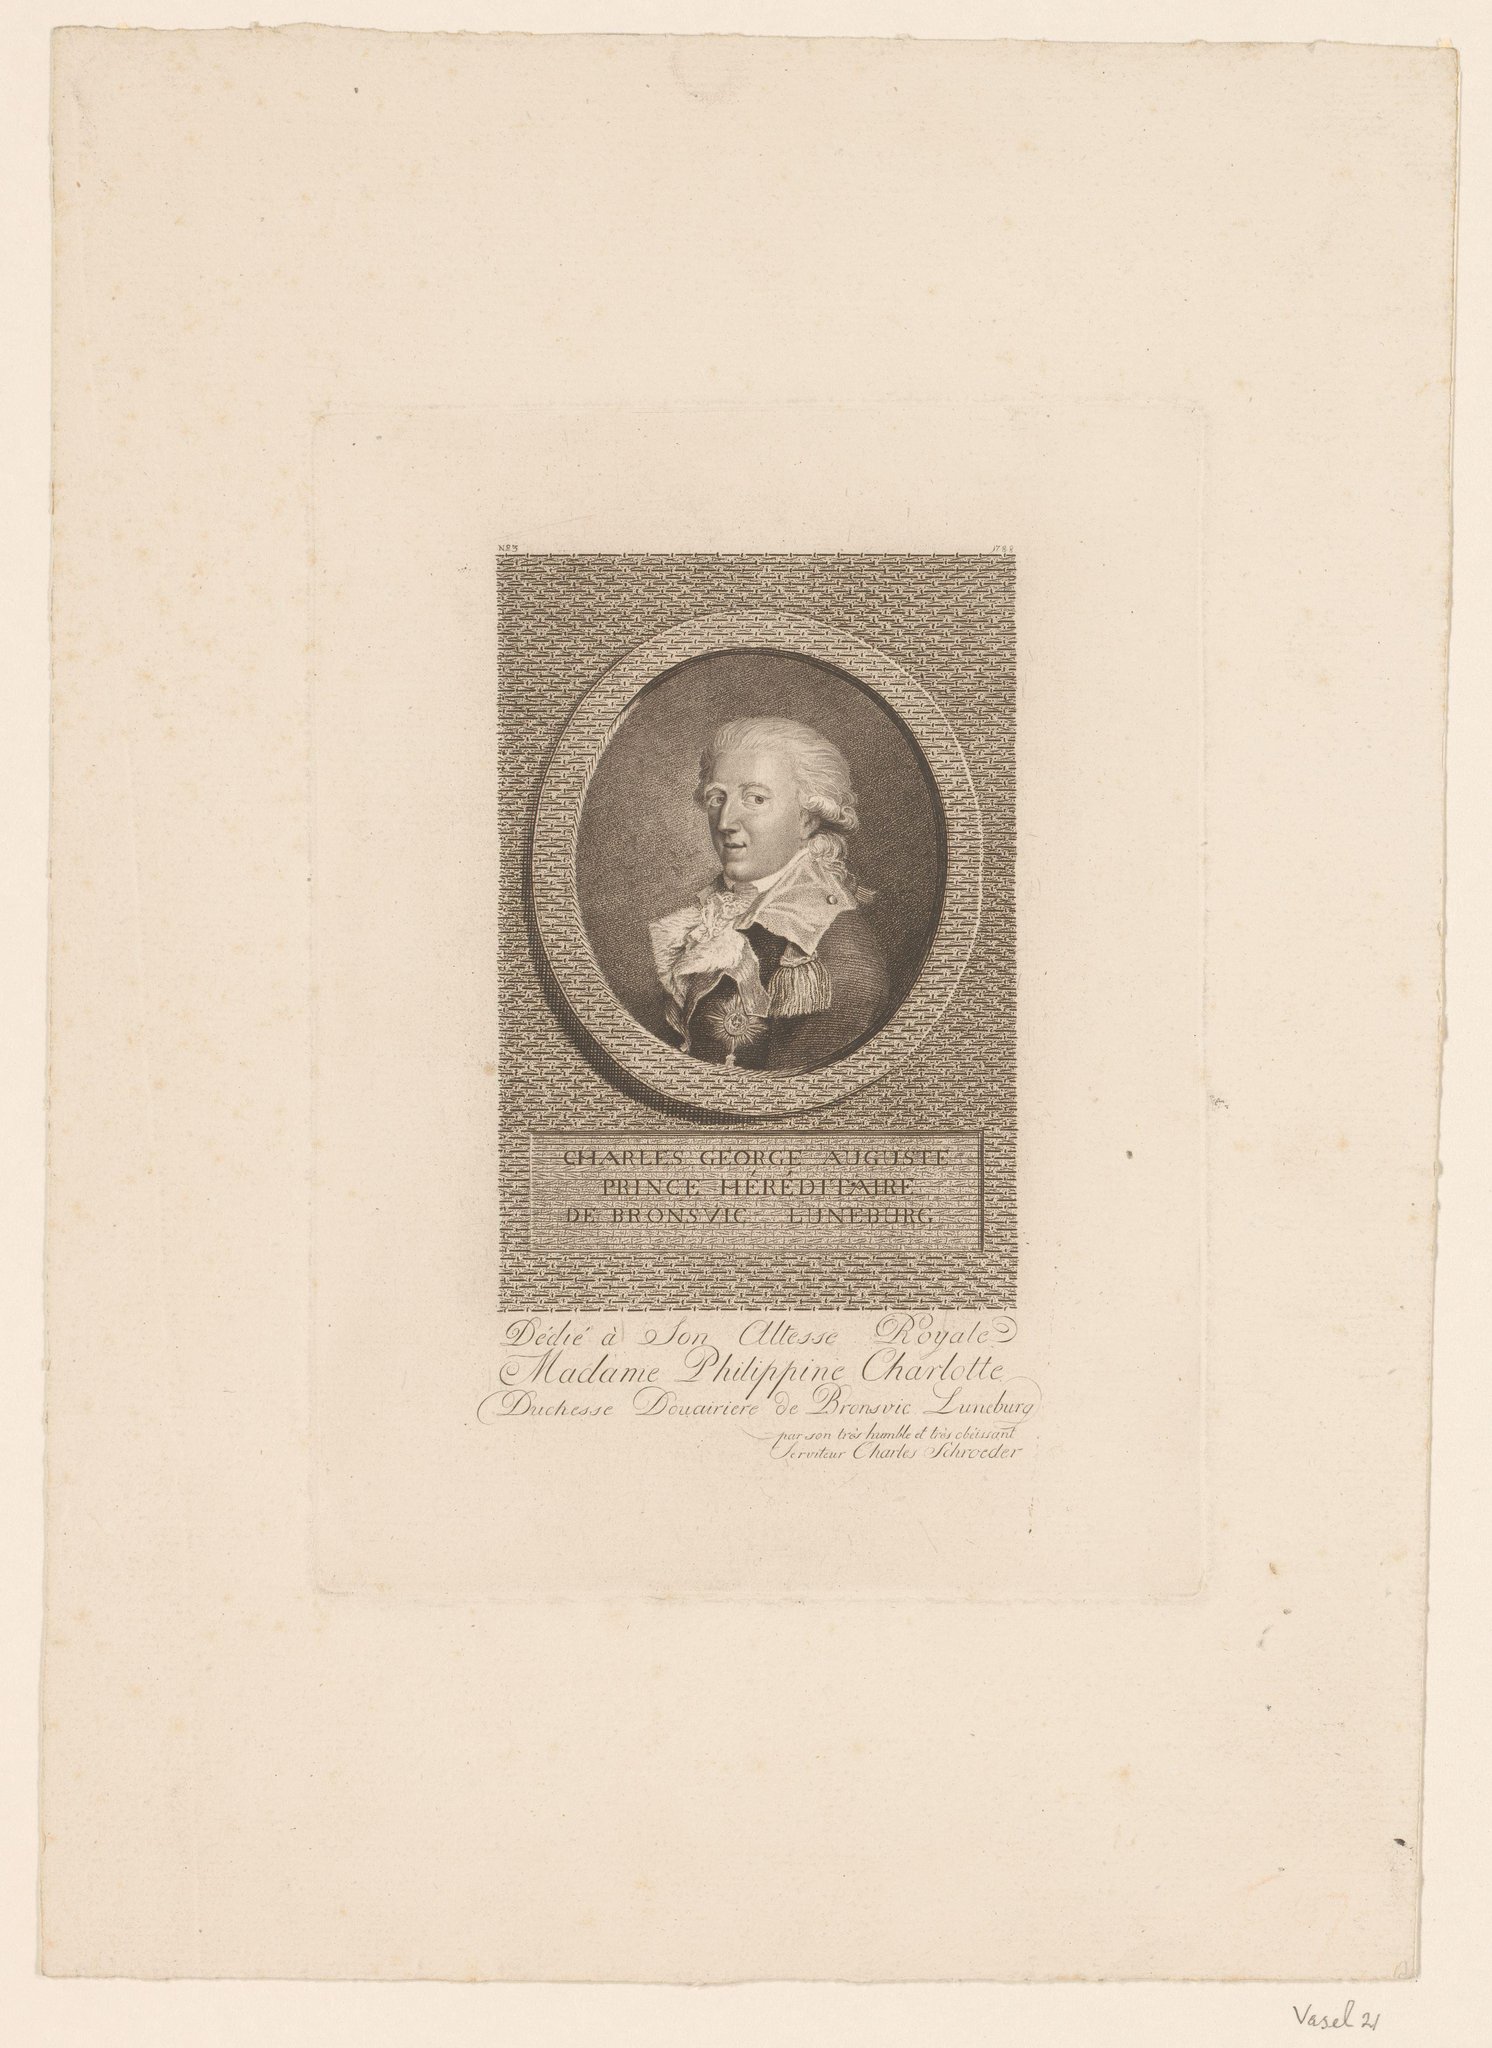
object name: print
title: Portret van Karel van Brunswijk-Wolfenbüttel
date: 1788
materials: paper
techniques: etching, engraving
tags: karel van brunswijk-wolfenbüttel, historical persons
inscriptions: collector's mark: Lugt 2228